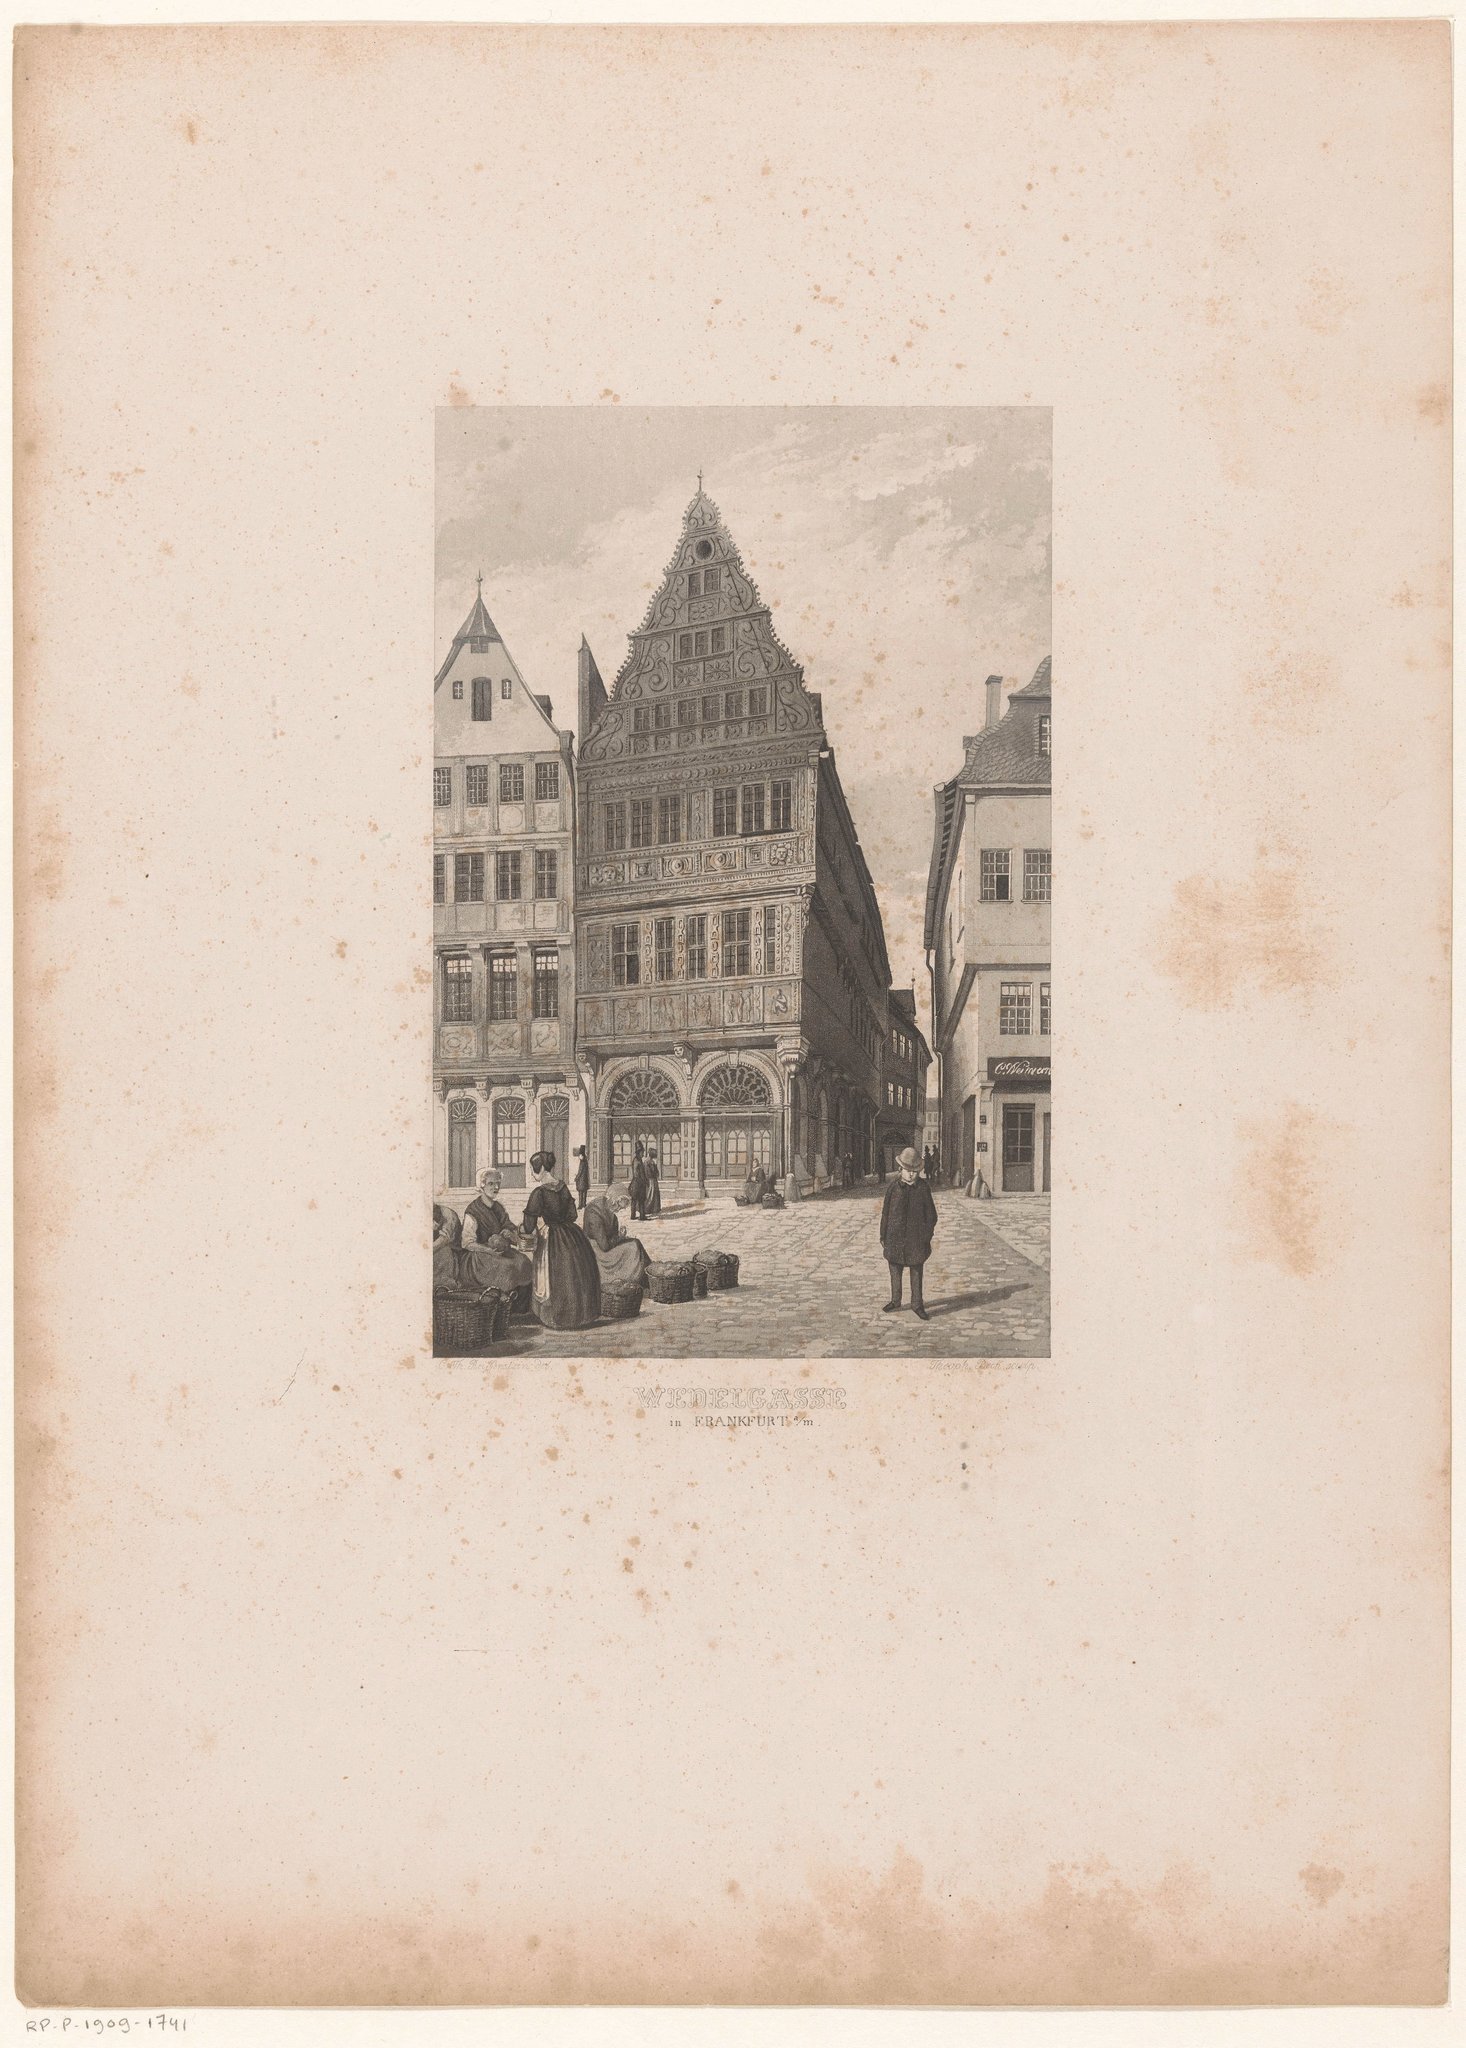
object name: print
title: Gezicht op het Salzhaus te Frankfurt am Main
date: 1843-1903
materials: paper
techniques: aquatint, etching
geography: frankfurt am main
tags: façade (of house or building)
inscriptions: collector's mark: Lugt 2228